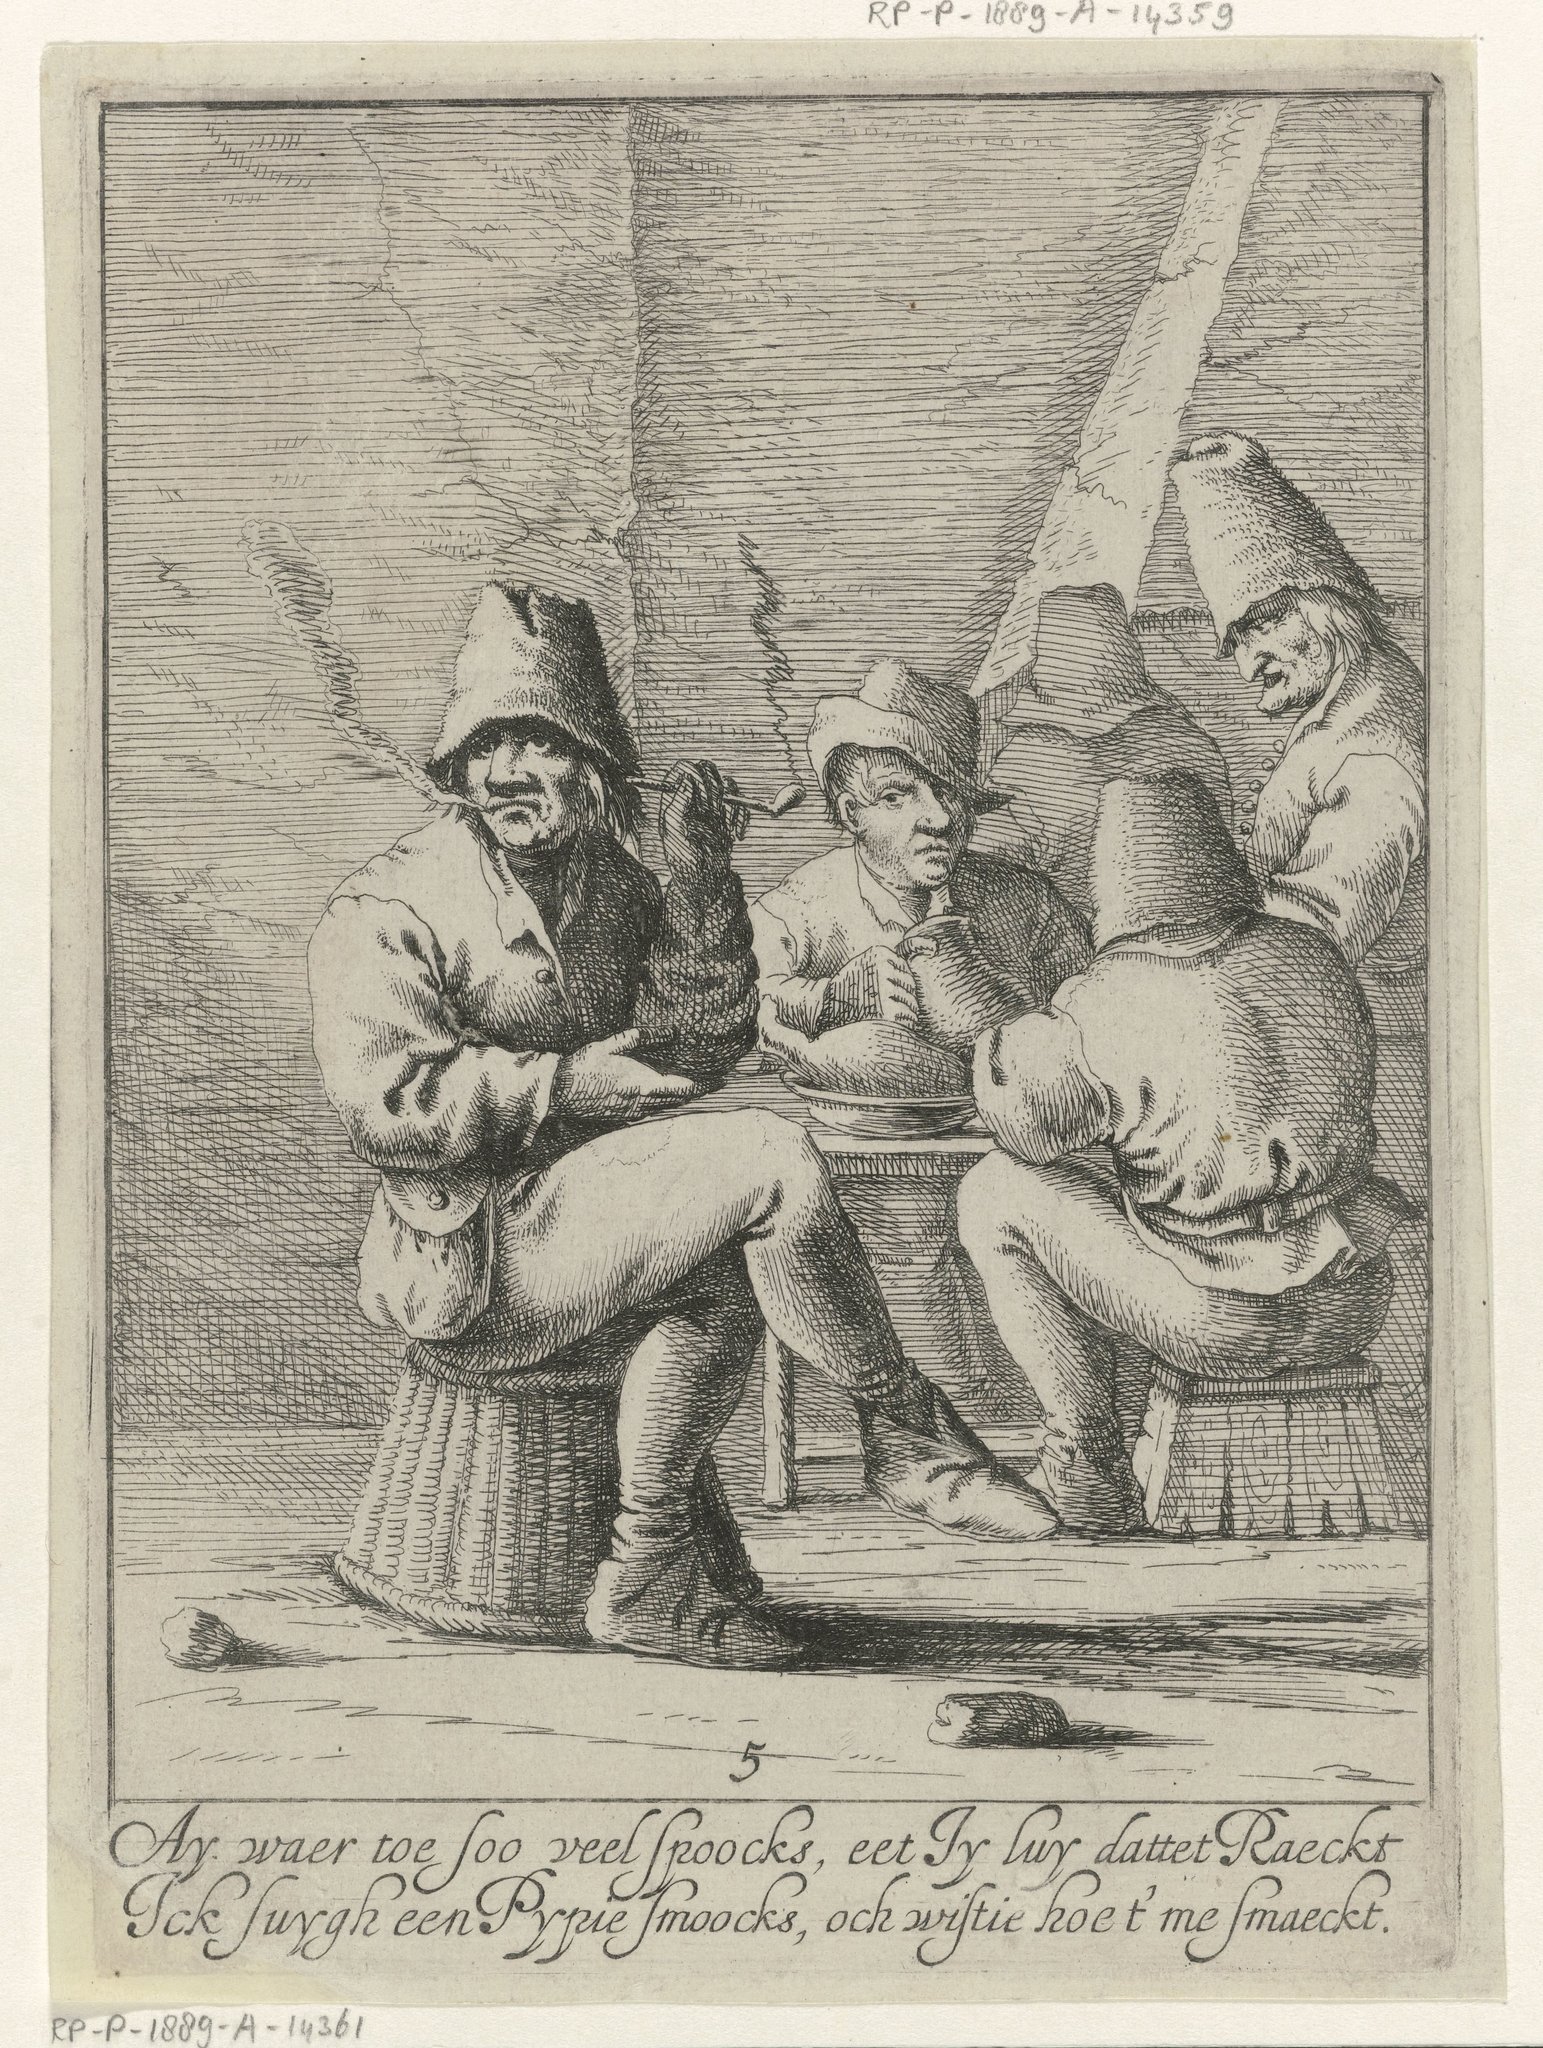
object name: print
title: Smaak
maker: isaac vos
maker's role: publisher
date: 1600-1670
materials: paper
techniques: etching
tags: taste, tasting (one of the five senses), pipe ~ tobacco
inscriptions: collector's mark: Lugt 2228, caption: ‘Ay, waer toe soo veel spoocks, eet Jy luy dattet Raeckt / Ick suygh een Pypie smoocks, och wistie hoe t'me smaeckt’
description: Een man rookt in een herberg een pijp. Hij zit op een omgekeerde mand met de benen over elkaar geslagen. Op de achtergrond vier figuren. Onder de voorstelling een tweeregelig vers in het Nederlands. De prent maakt deel uit van een serie van vijf prenten met de vijf zintuigen.